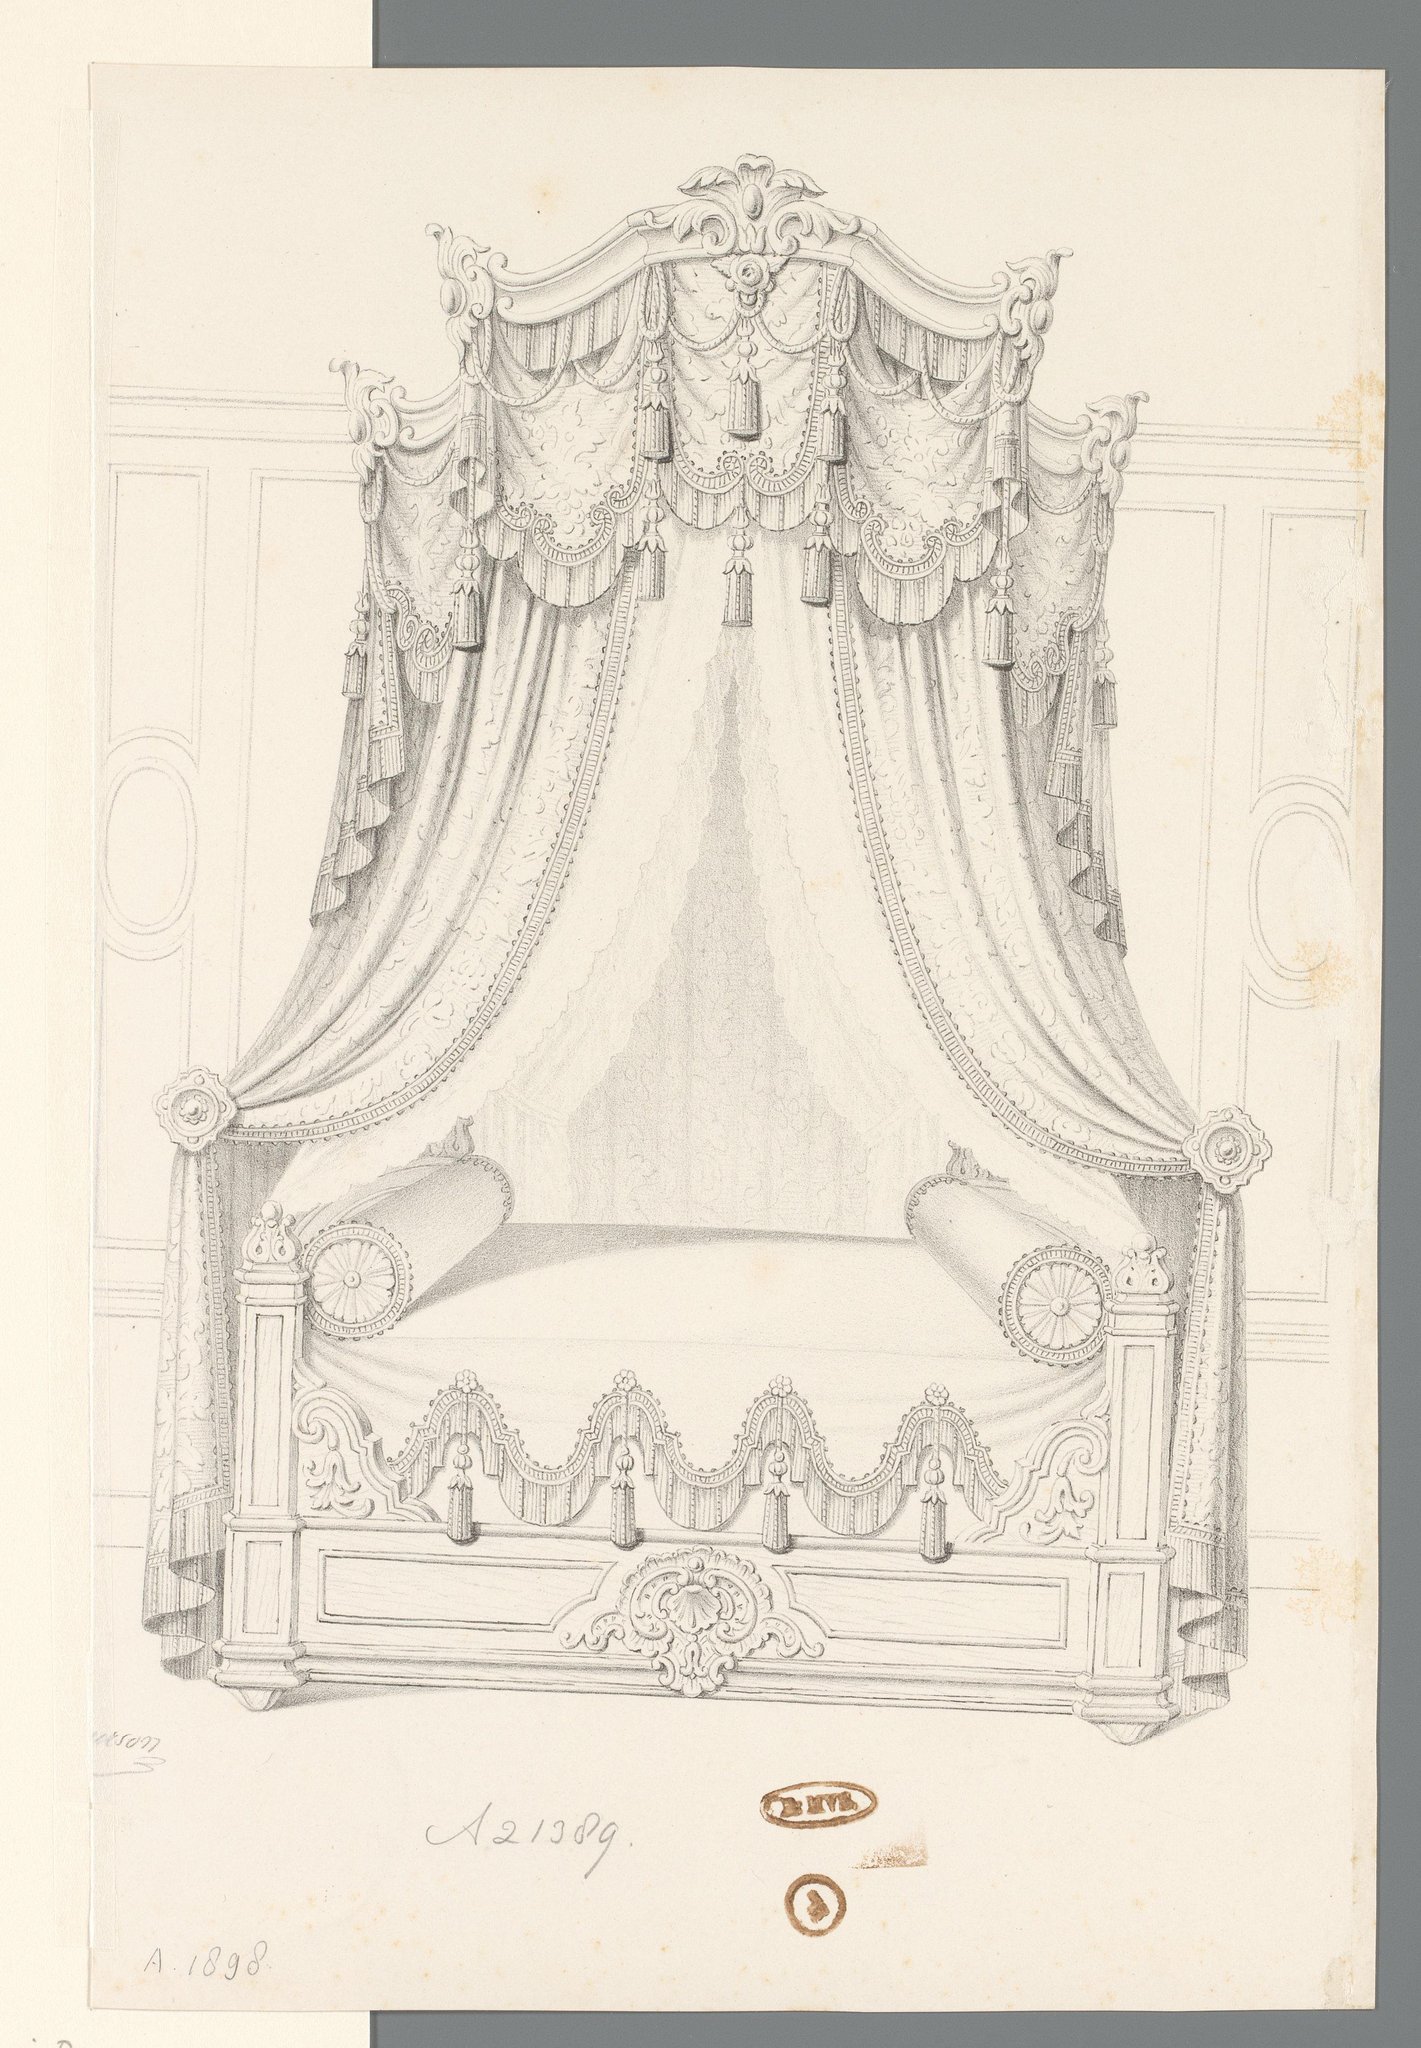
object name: print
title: Hemelbed met rolkussens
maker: Anonymous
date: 1857-1858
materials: paper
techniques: lithograph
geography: paris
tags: canopy, baldachin, four poster bed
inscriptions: collector's mark: Lugt 964